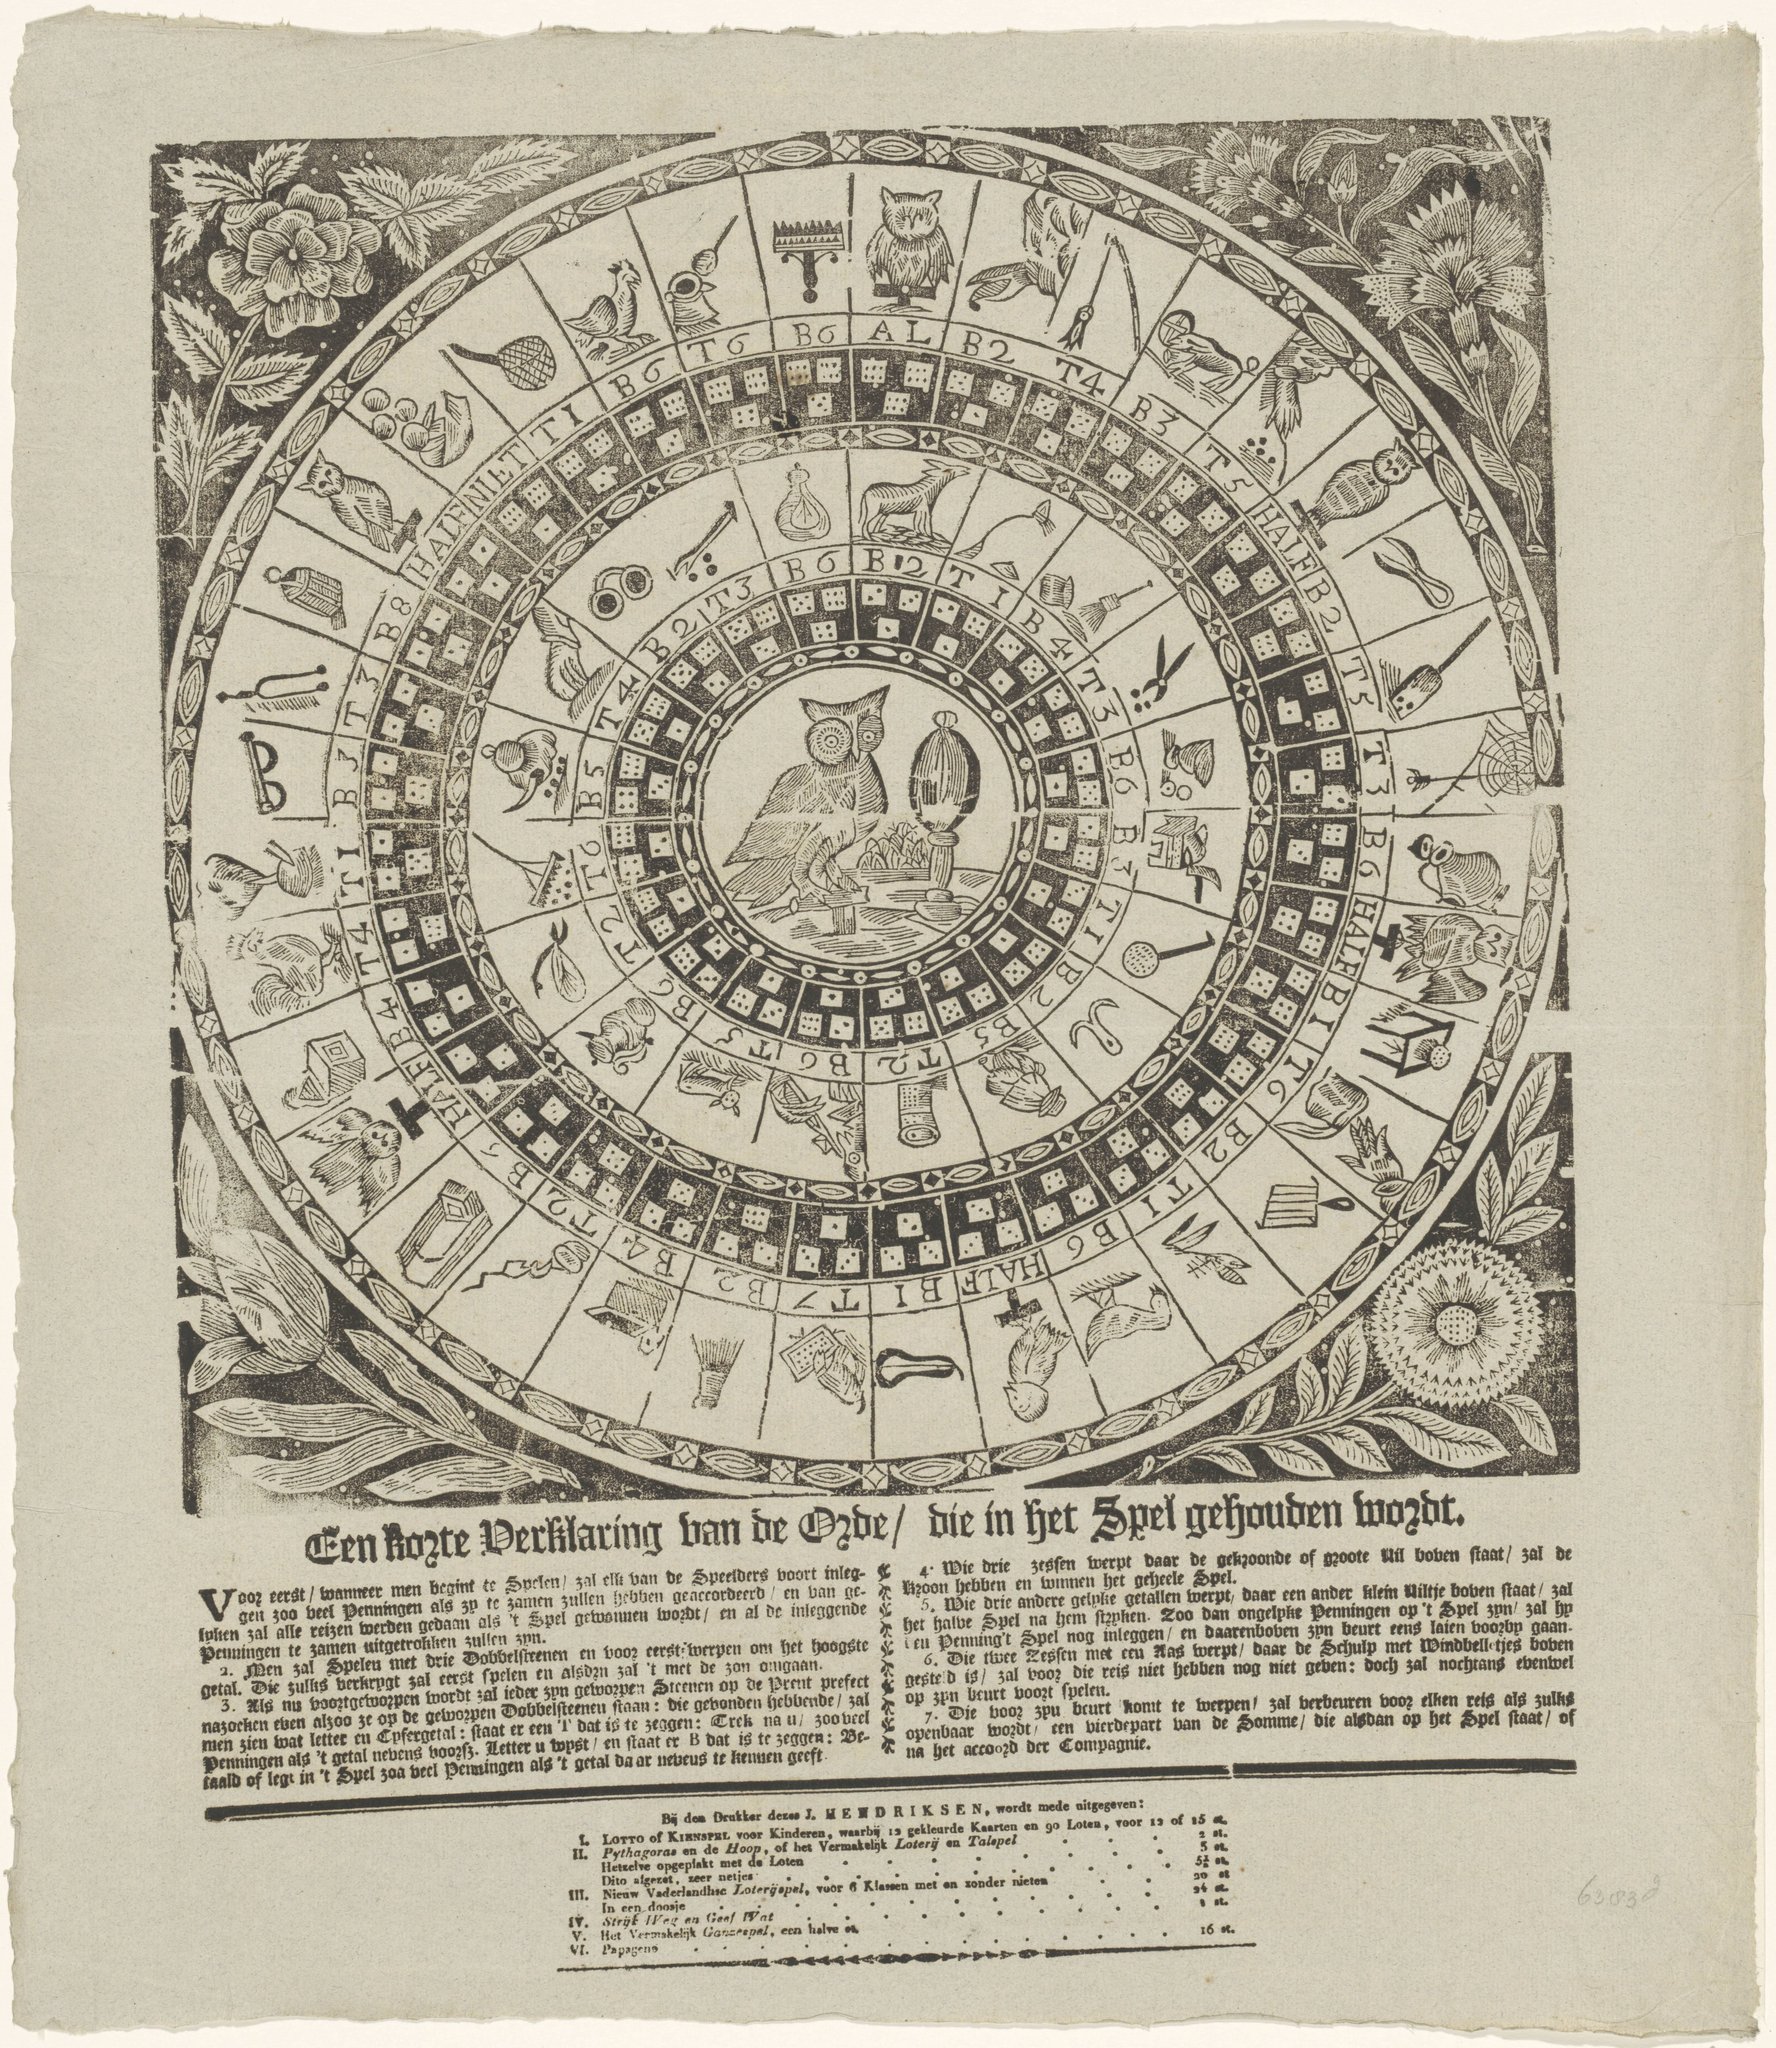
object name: print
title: Uilenspel, ca. 1780-1830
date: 1781-1828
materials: paper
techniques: letterpress printing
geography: netherlands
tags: board-games of chance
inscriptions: collector's mark: Lugt 2228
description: Uilenbordspel met in het midden een uil en onderaan de spelregels. Onder de spelregels een lijst van andere bordspelen verkrijgbaar bij deze drukker. Onderdeel van een groep van kinder- en gezelschapsspelen gedrukt in de periode ca. 1750-1850.